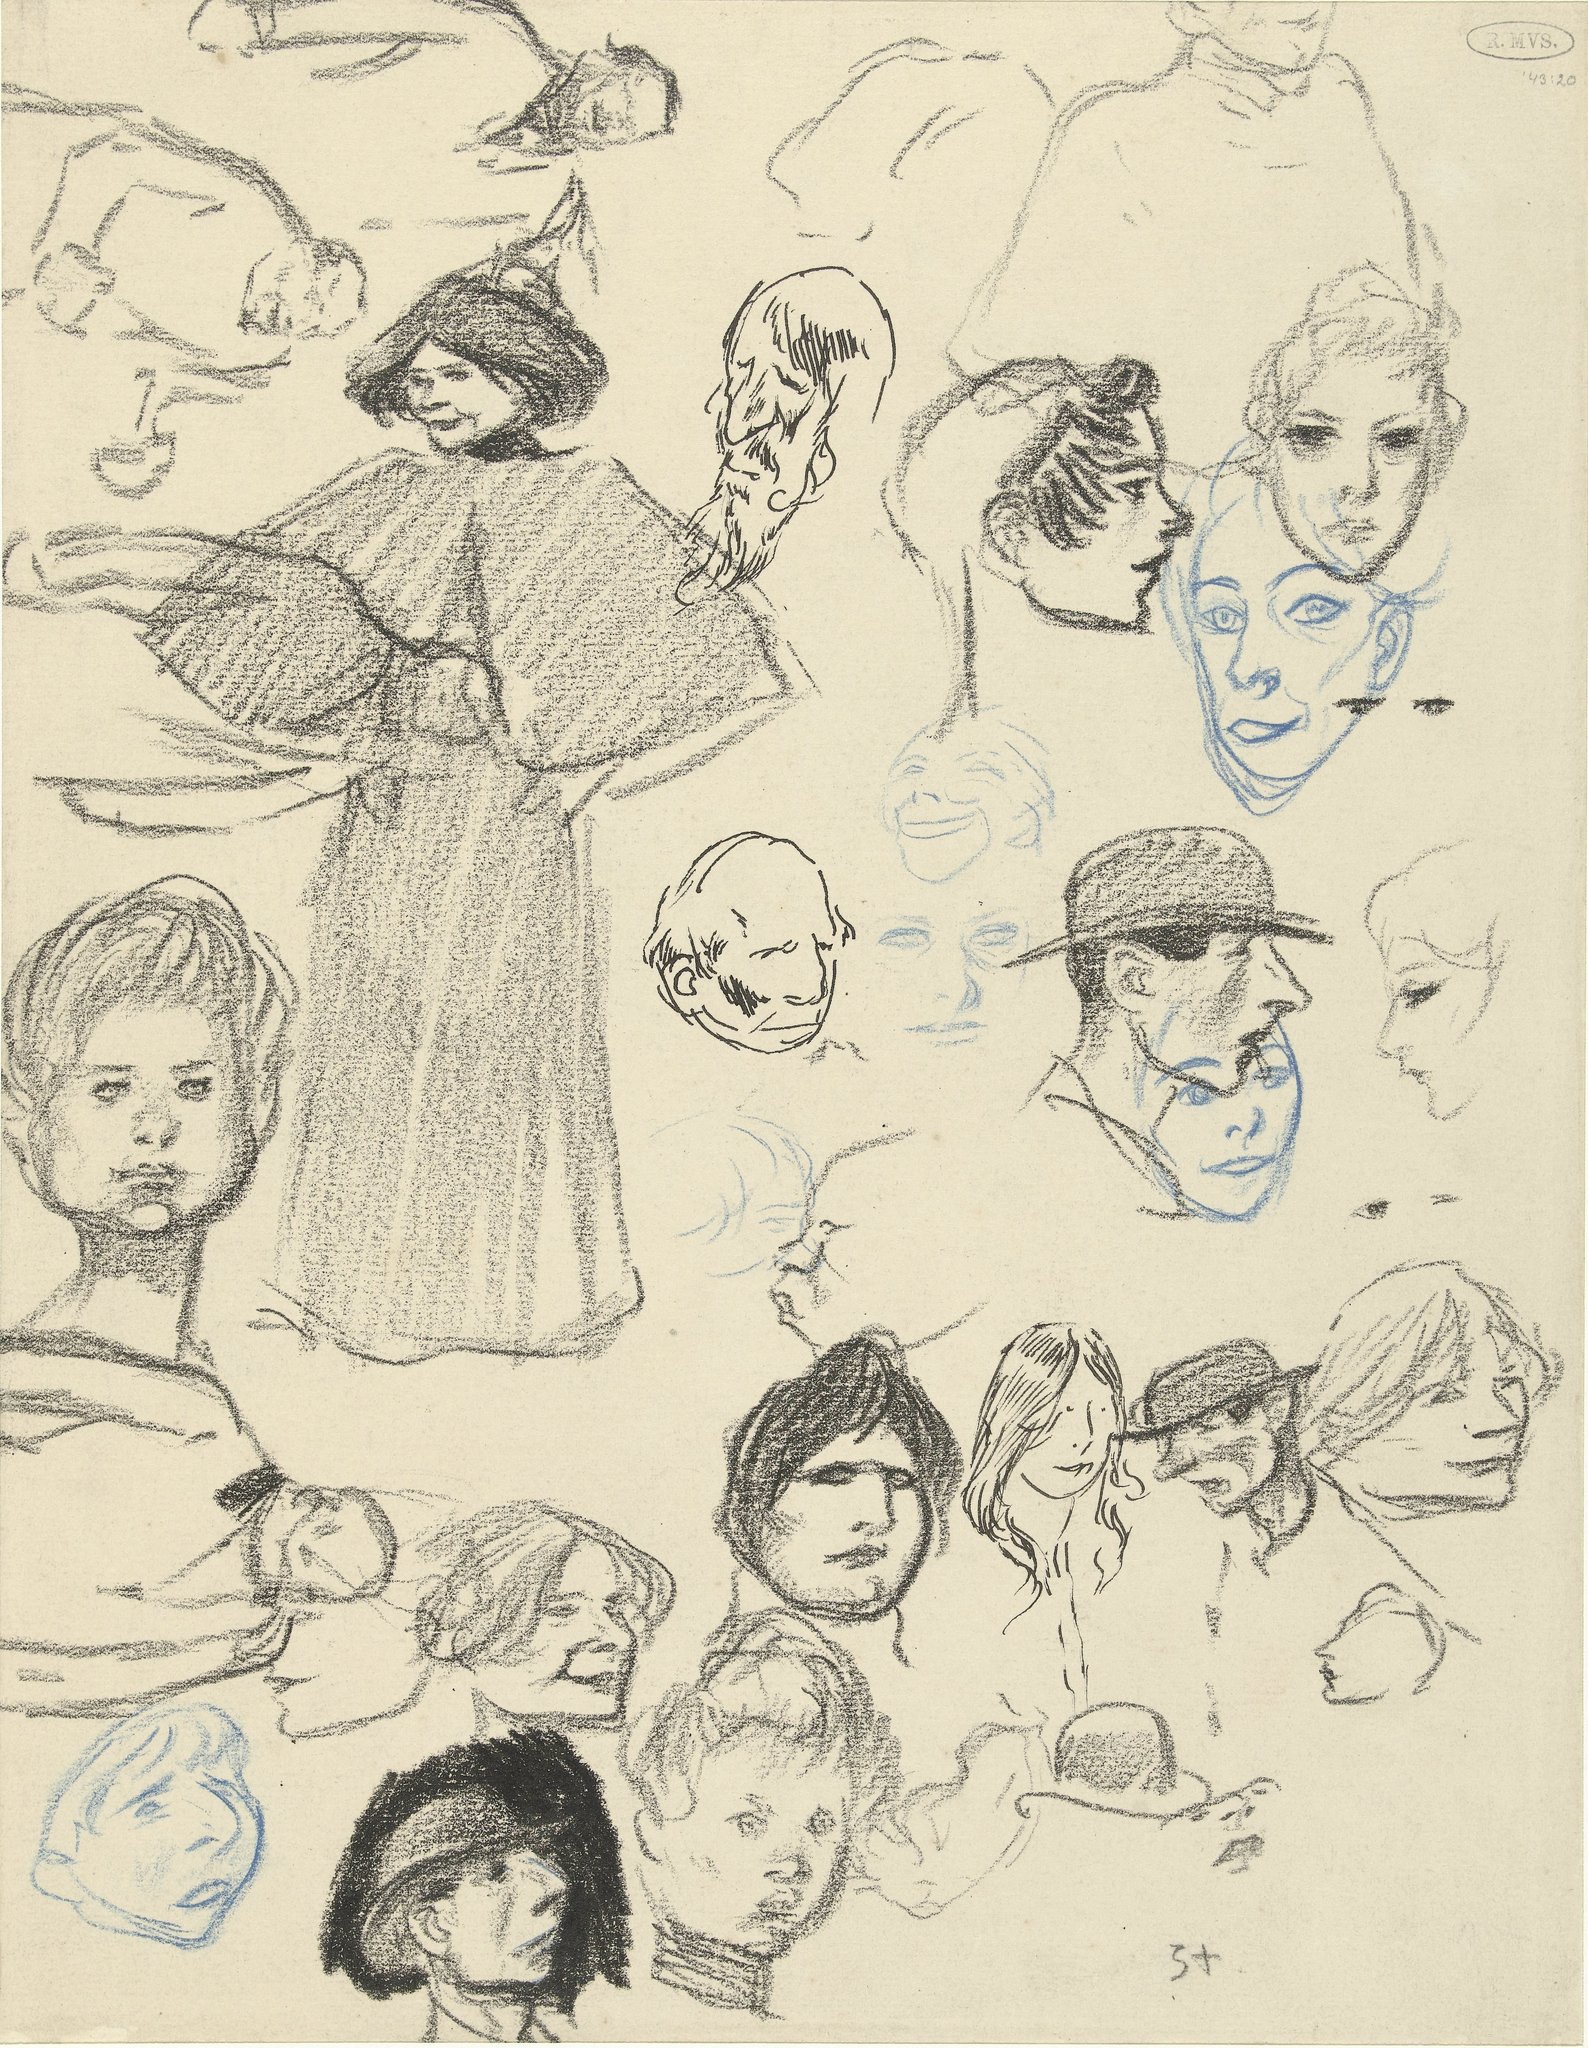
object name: drawing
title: Diverse portret- en figuurstudies van vrouwen en mannen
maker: théophile alexandre steinlen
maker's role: draughtsman, painter, print maker, sculptor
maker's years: 1859-1923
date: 1869-1923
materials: chalk, ink, paper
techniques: pen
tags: head (human) - aa - female human figure